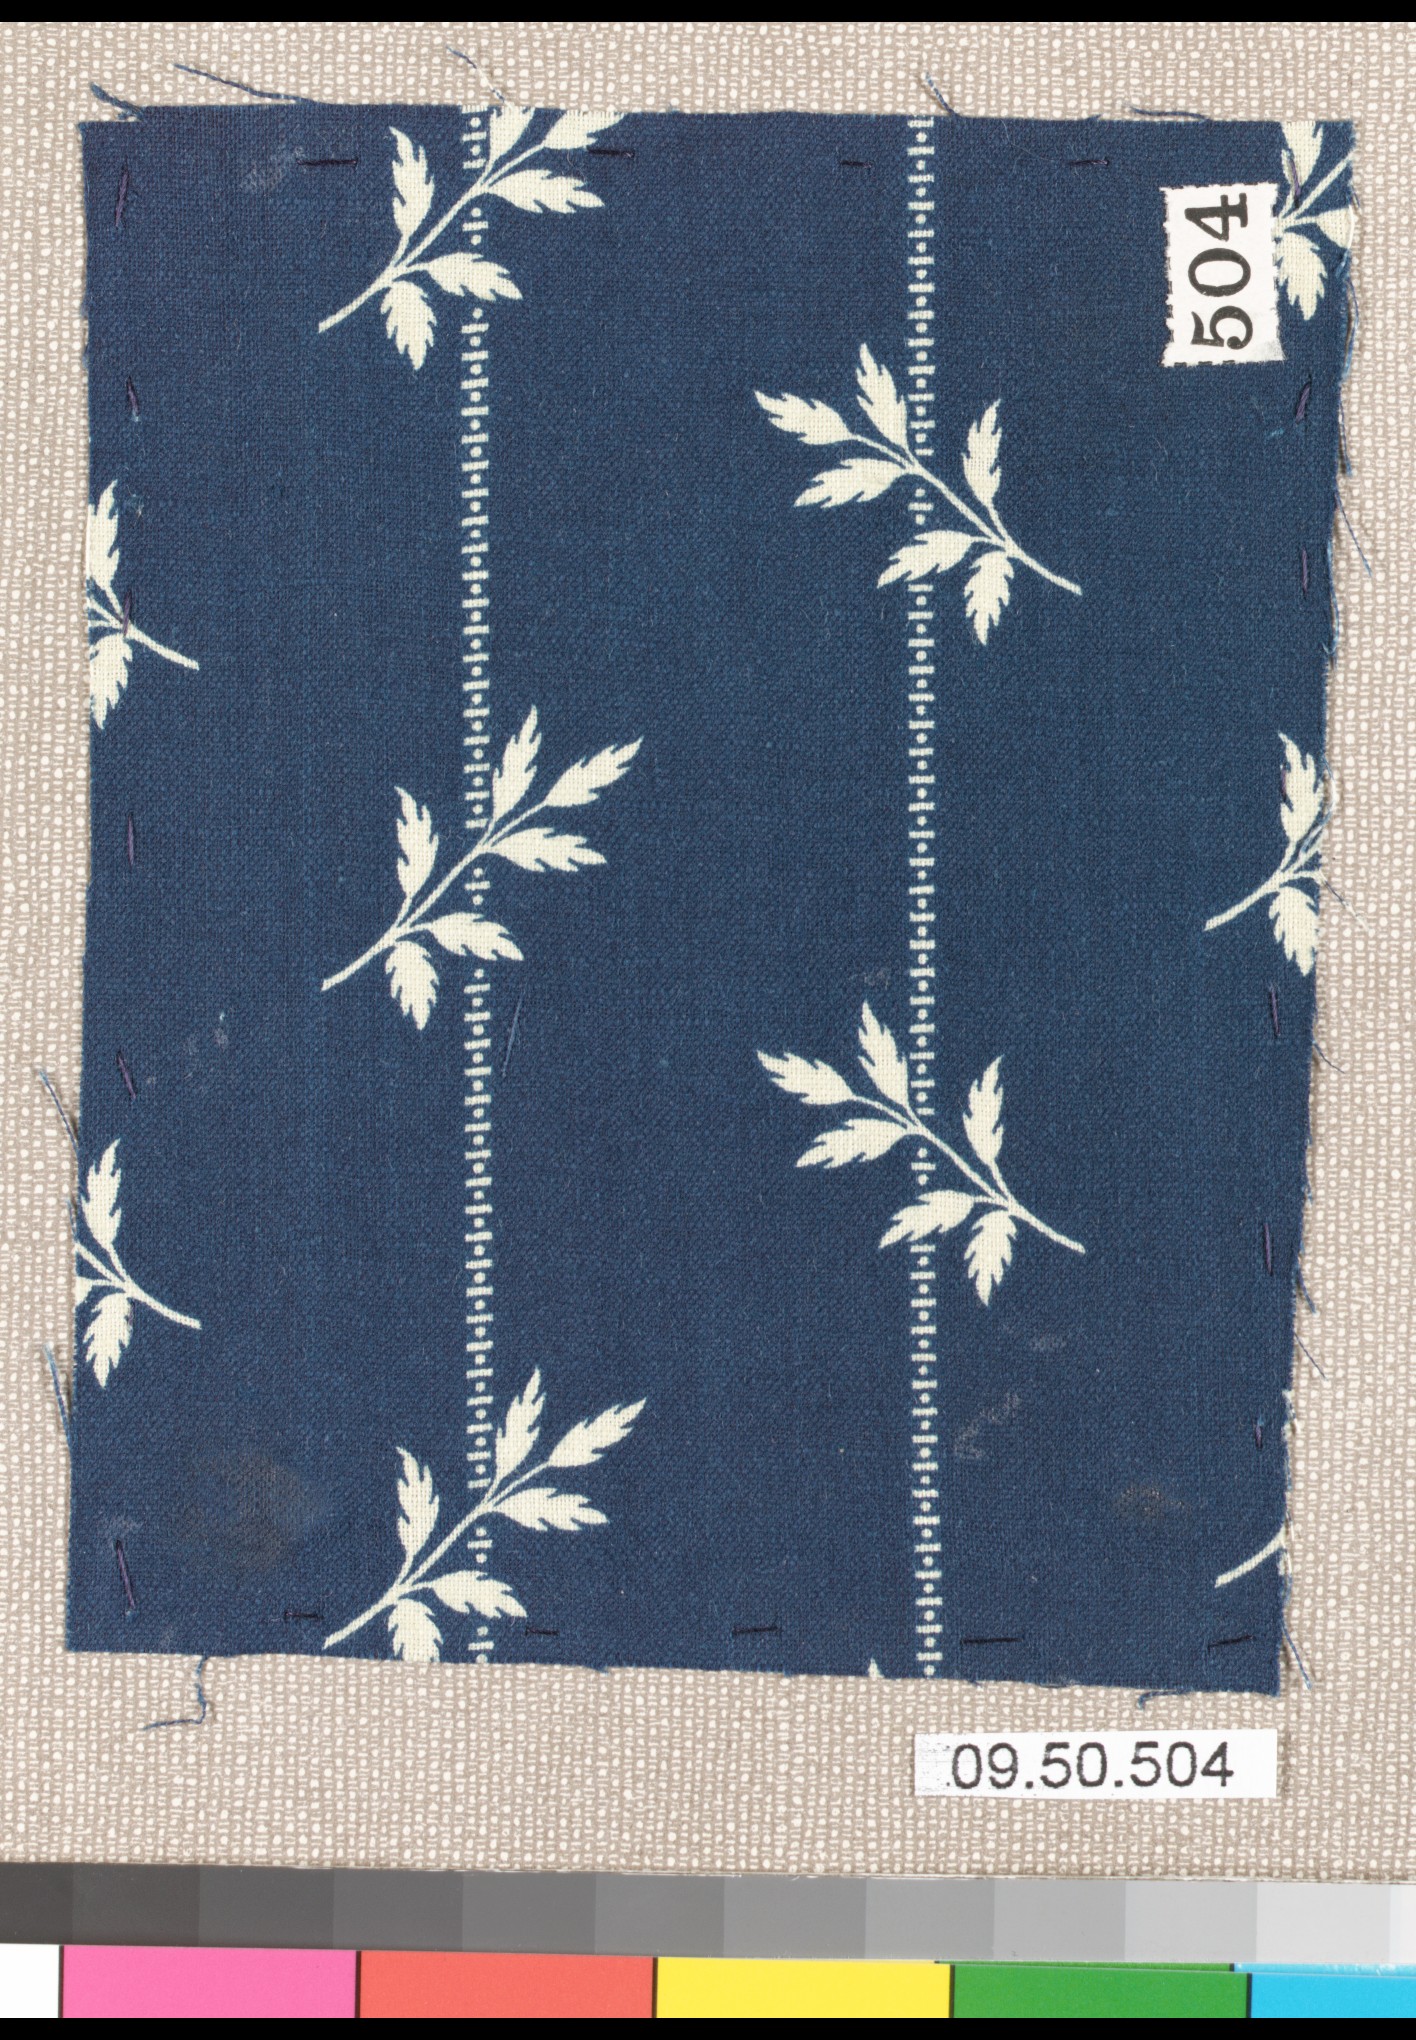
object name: piece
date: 1801-1900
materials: cotton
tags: leaves